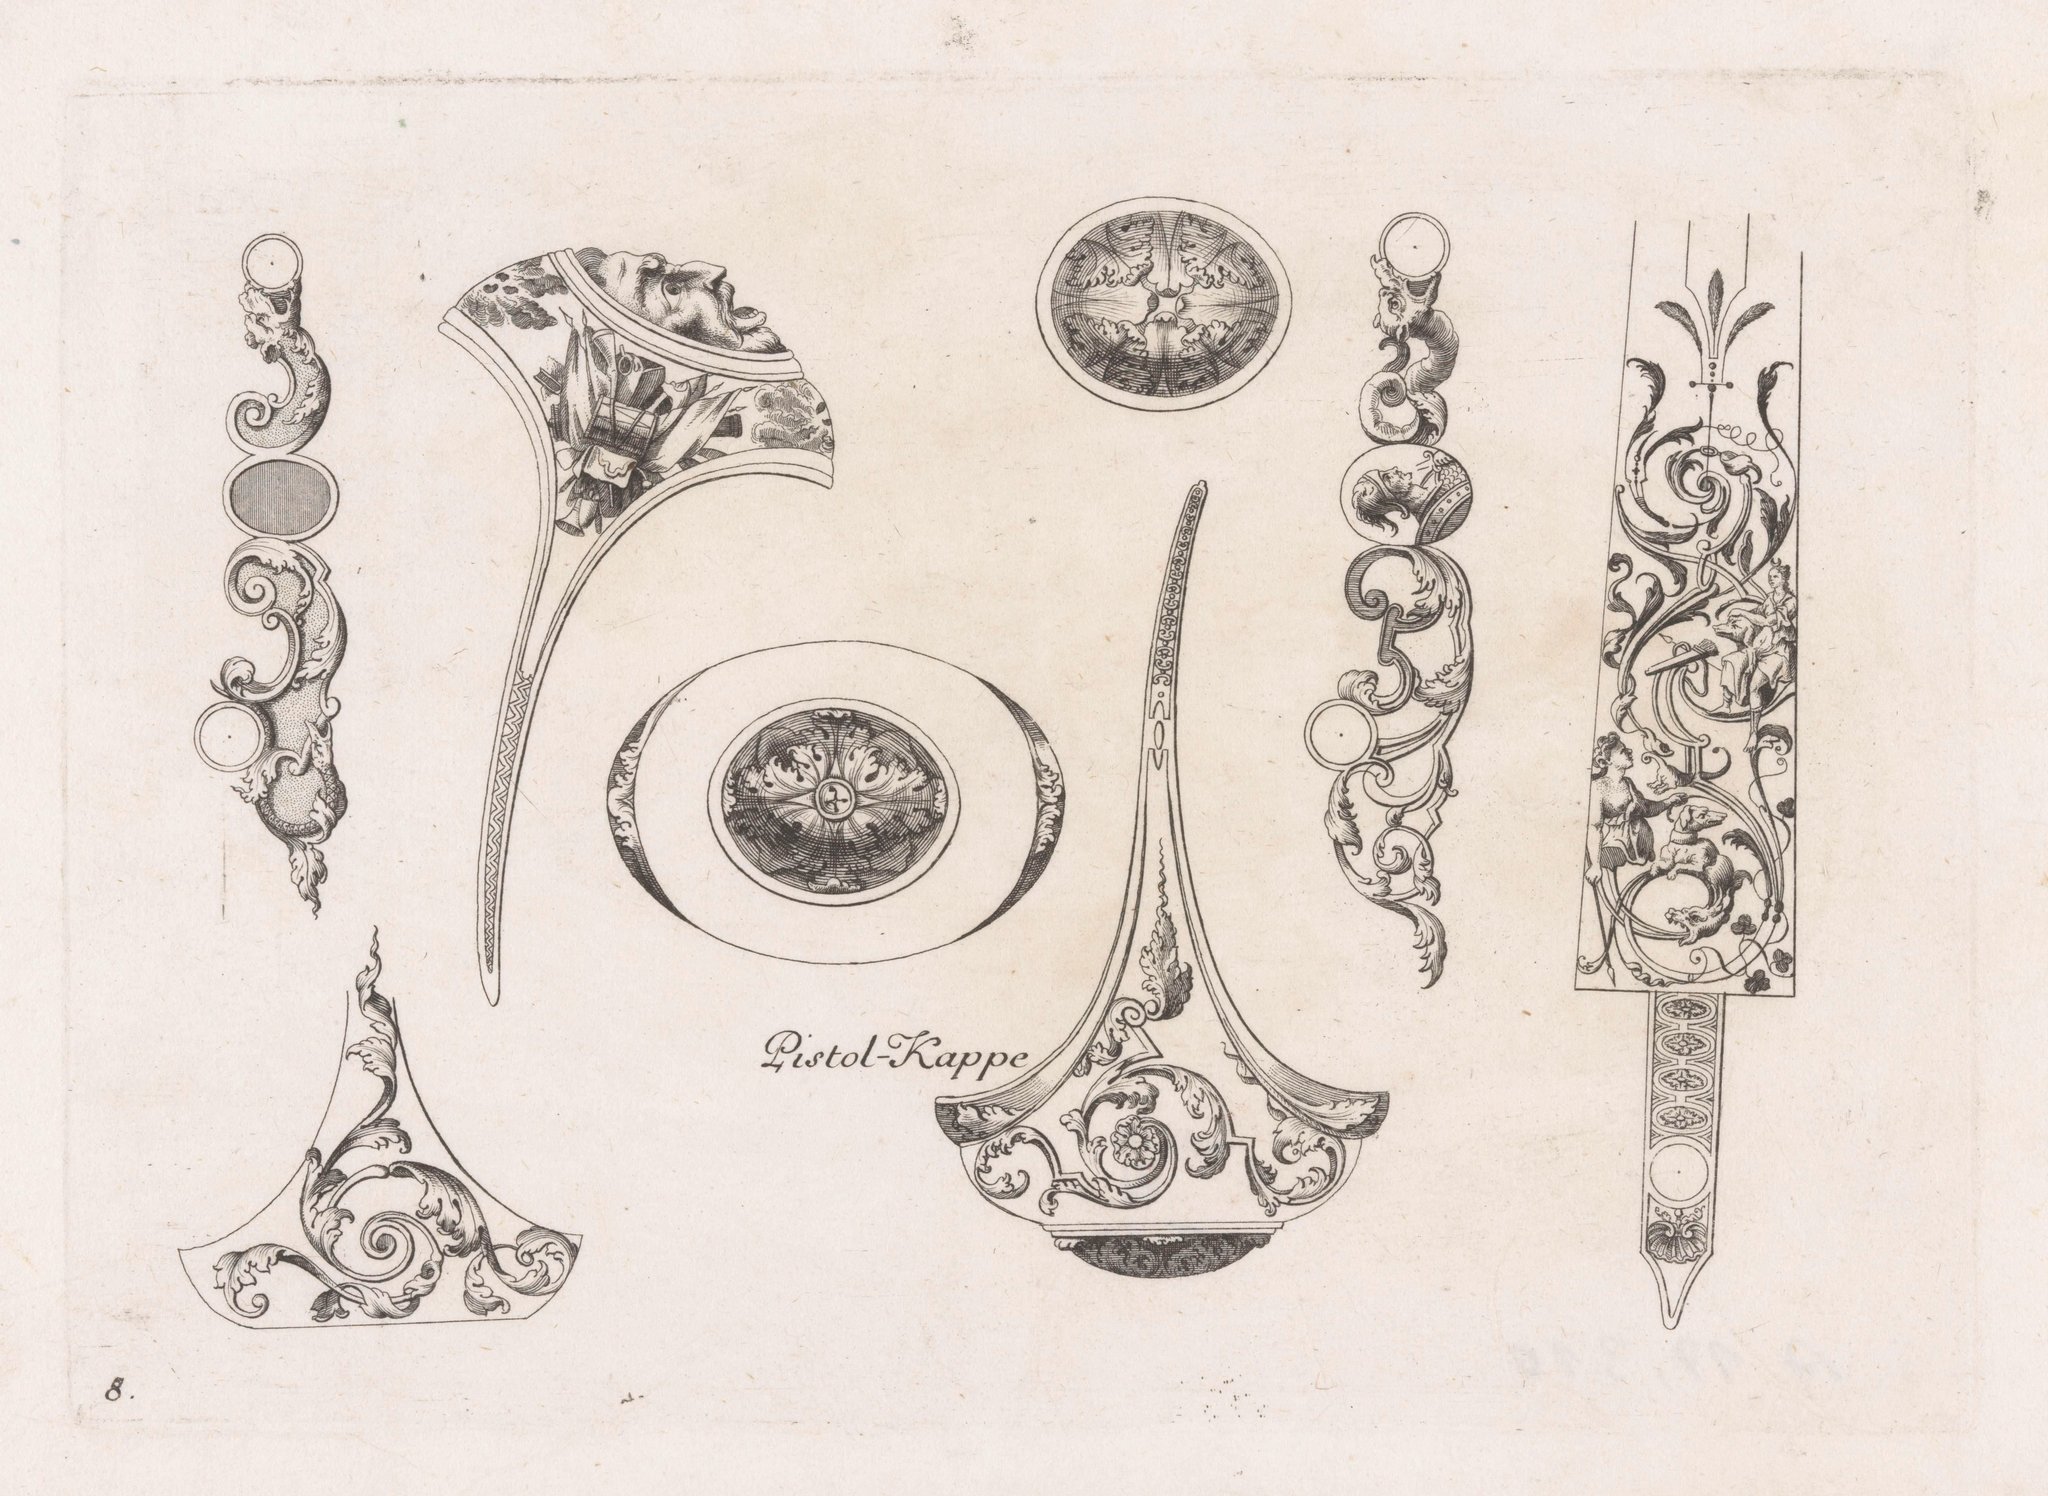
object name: print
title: Onderdelen van vuurwapens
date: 1690-1725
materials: paper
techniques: etching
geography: nuremberg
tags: weapons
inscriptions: collector's mark: Lugt 2228, collector's mark: Lugt 2760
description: Geornamenteerde onderdelen van vuurwapens zoals drie kolfkappen en twee schroefplaten. Met Duitse beschrijving.